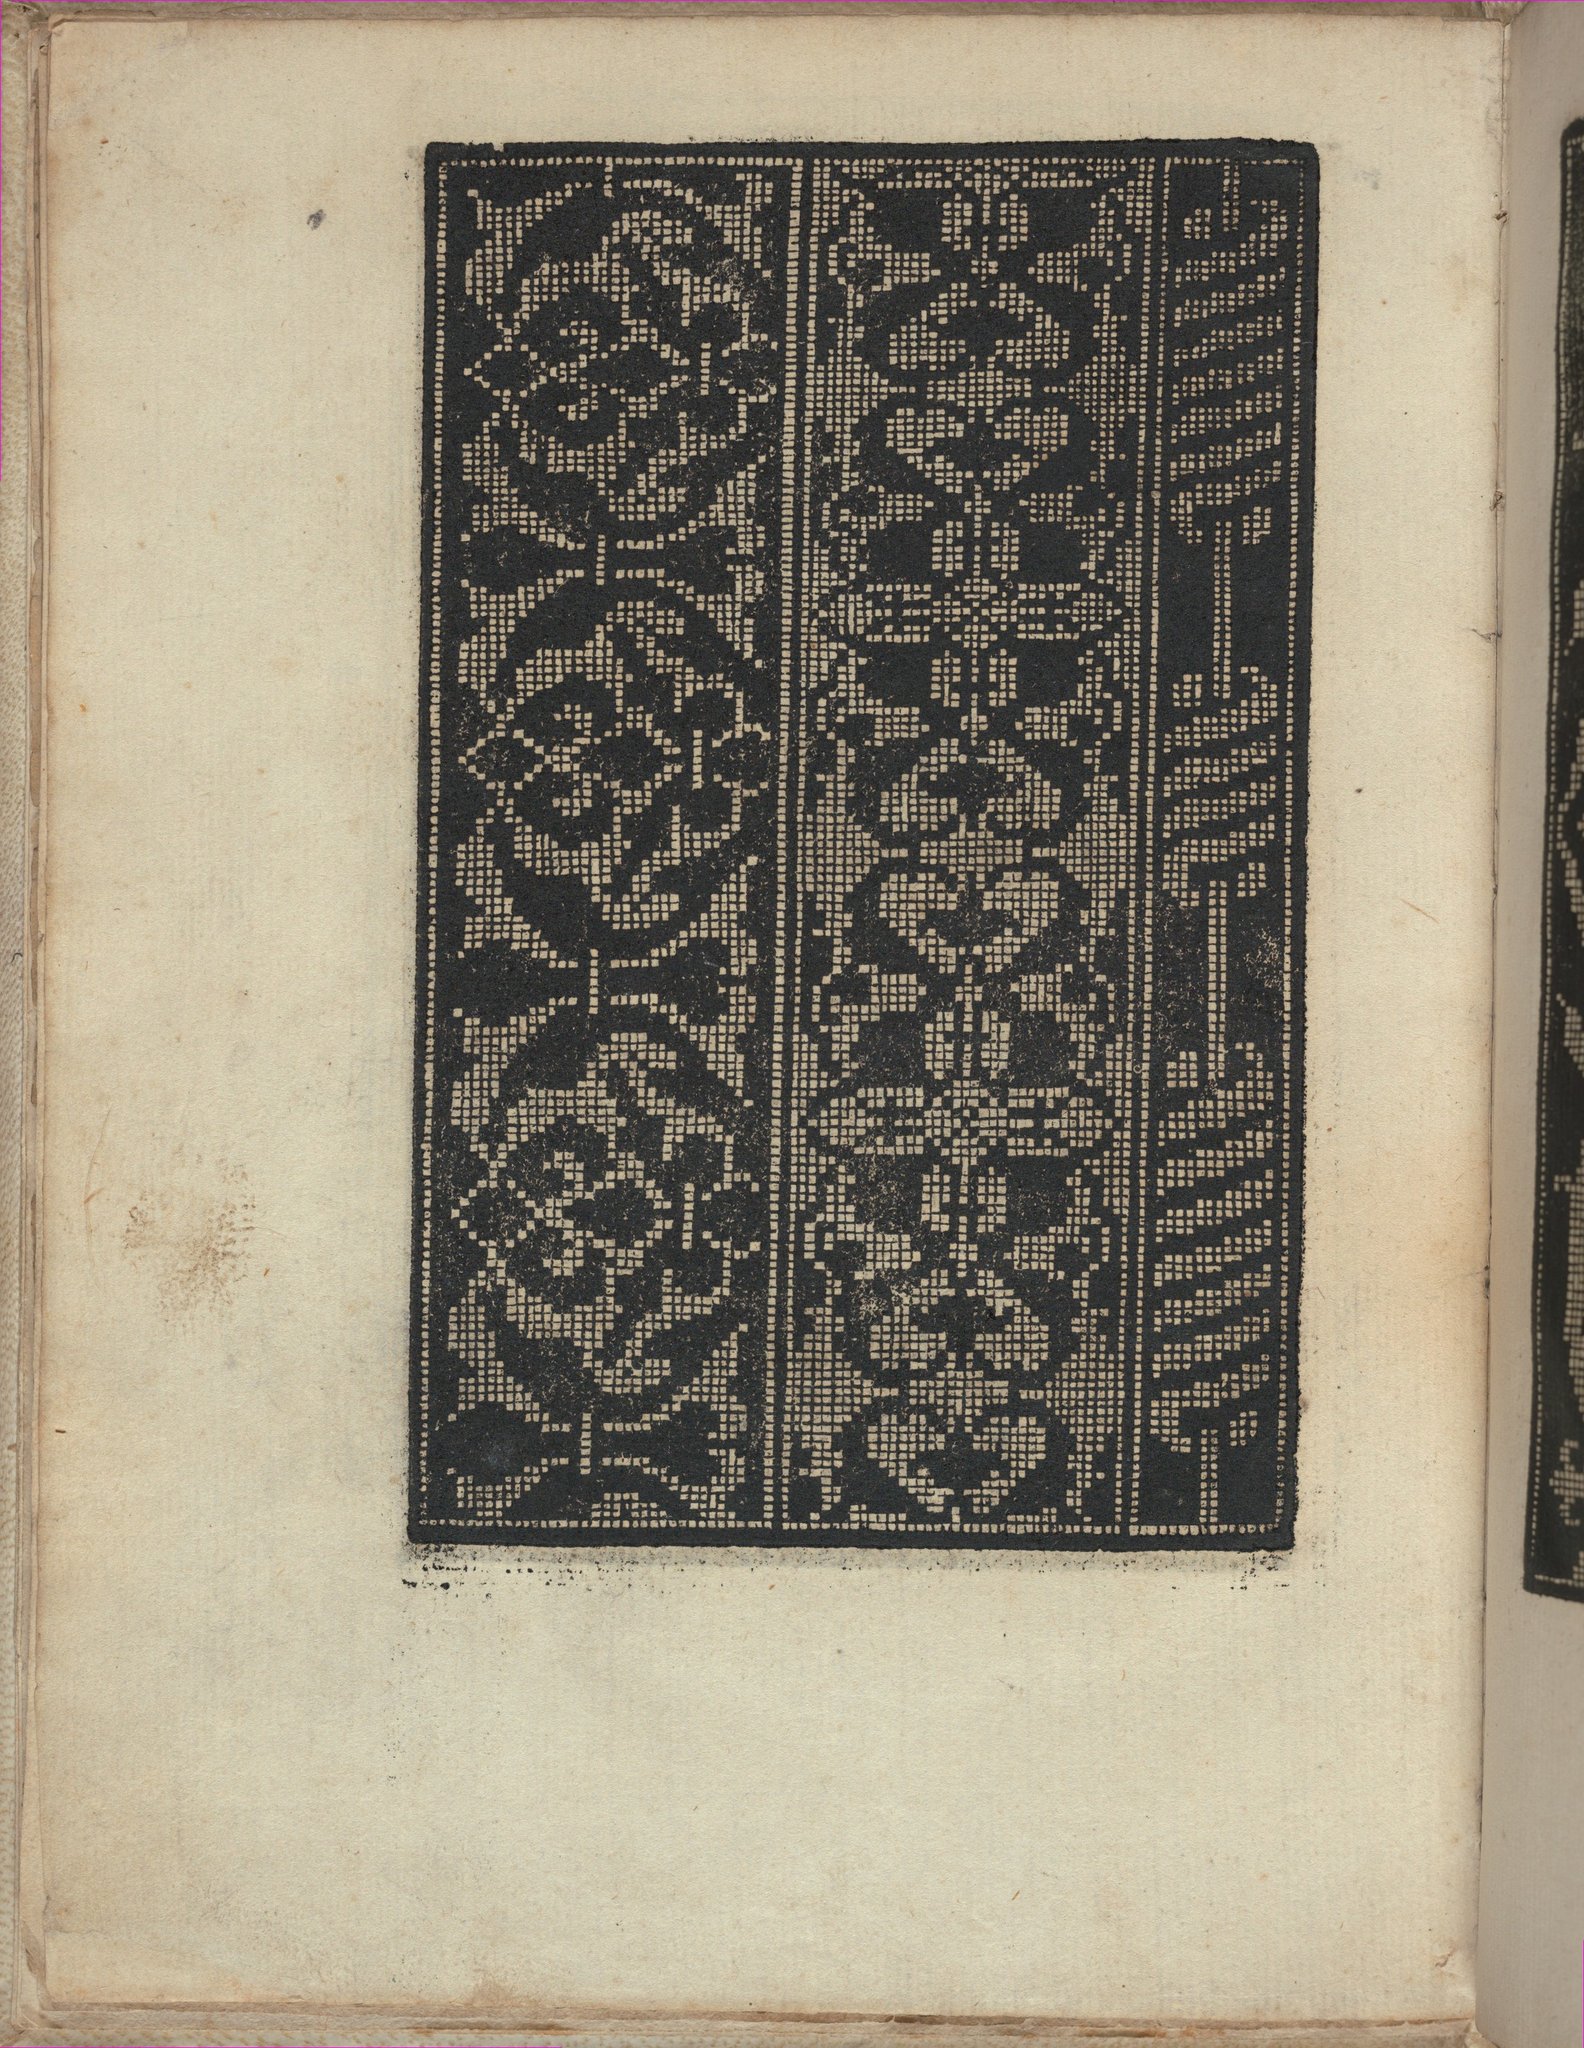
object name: book print ornament architecture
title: Esemplario di Lauori..., page 9 (verso)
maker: giovanni andrea vavassore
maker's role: publisher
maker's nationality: italian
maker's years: 1530-1573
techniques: woodcut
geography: venice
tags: ornament